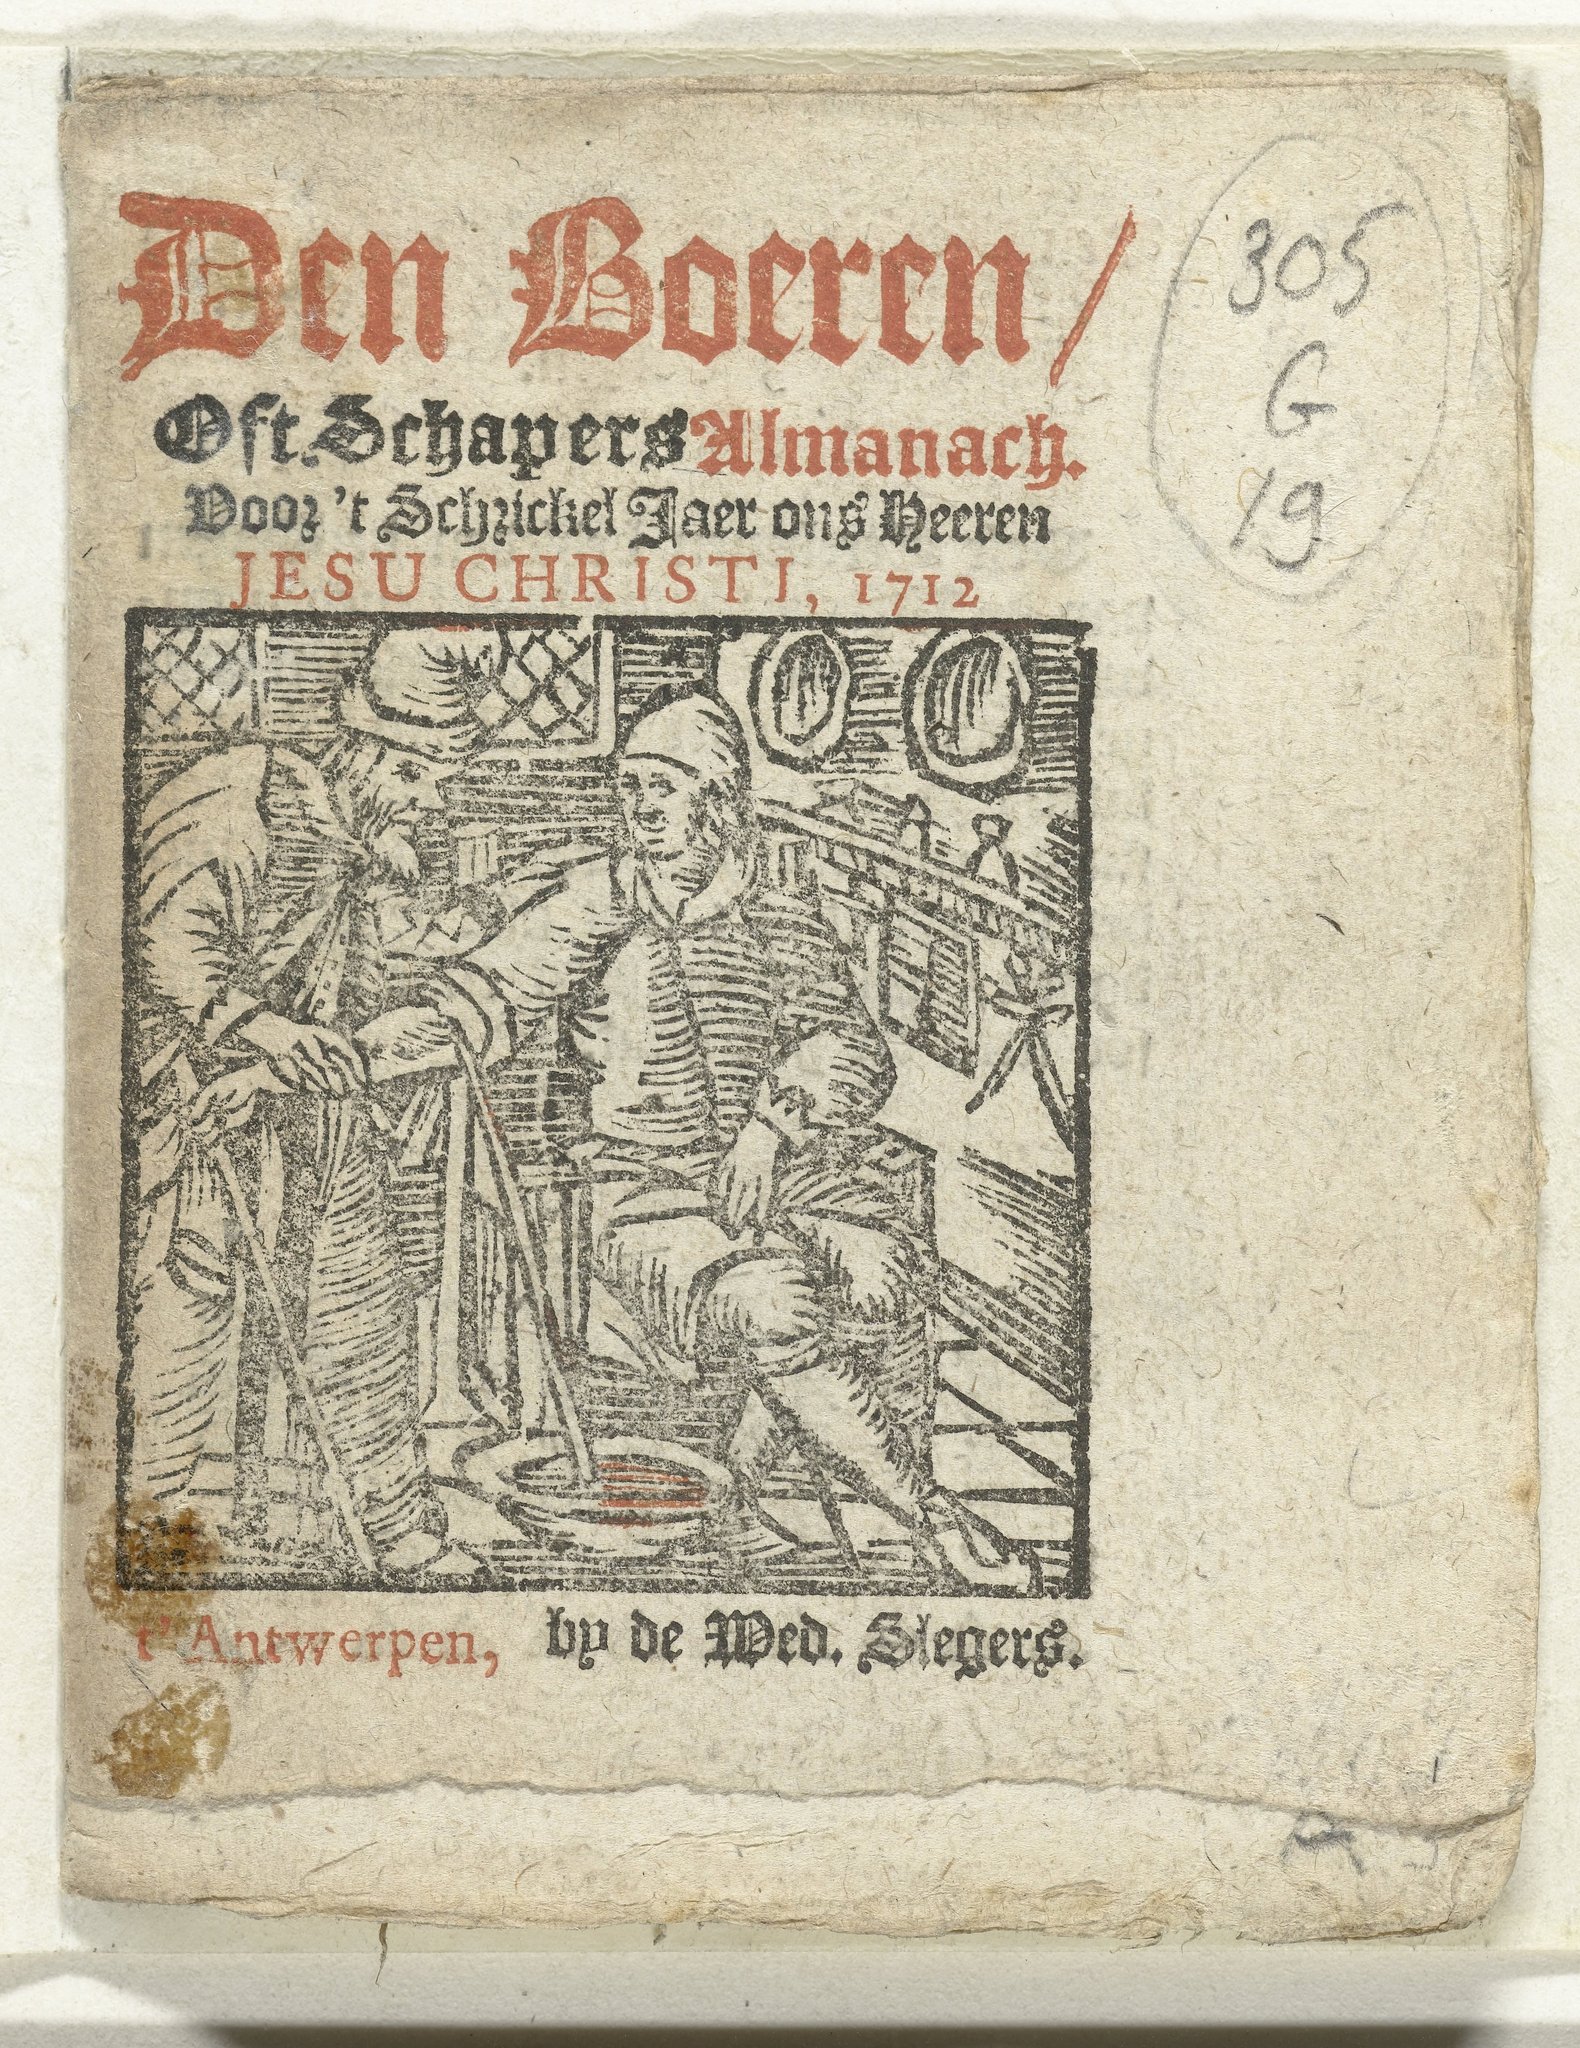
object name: titelblad, titelpagina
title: Titelpagina voor: Den Boeren / Oft Schapers Almanach Voor 't Schrickel Jaer ins Heeren Jesu Christi, 1712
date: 1712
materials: paper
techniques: letterpress printing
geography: low countries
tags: bleeding, blood-letting, e.g.: with the aid of cupping-glasses, calendar, almanac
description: Titelpagina in: Den Boeren / Oft Schapers Almanach Voor 't Schrickel Jaer ins Heeren Jesu Christi, 1712. Antwerpen: bij Wed. Slegers 1712. Exemplaar in de Rijksmuseum Research Library (signatuur: 305 G 19).